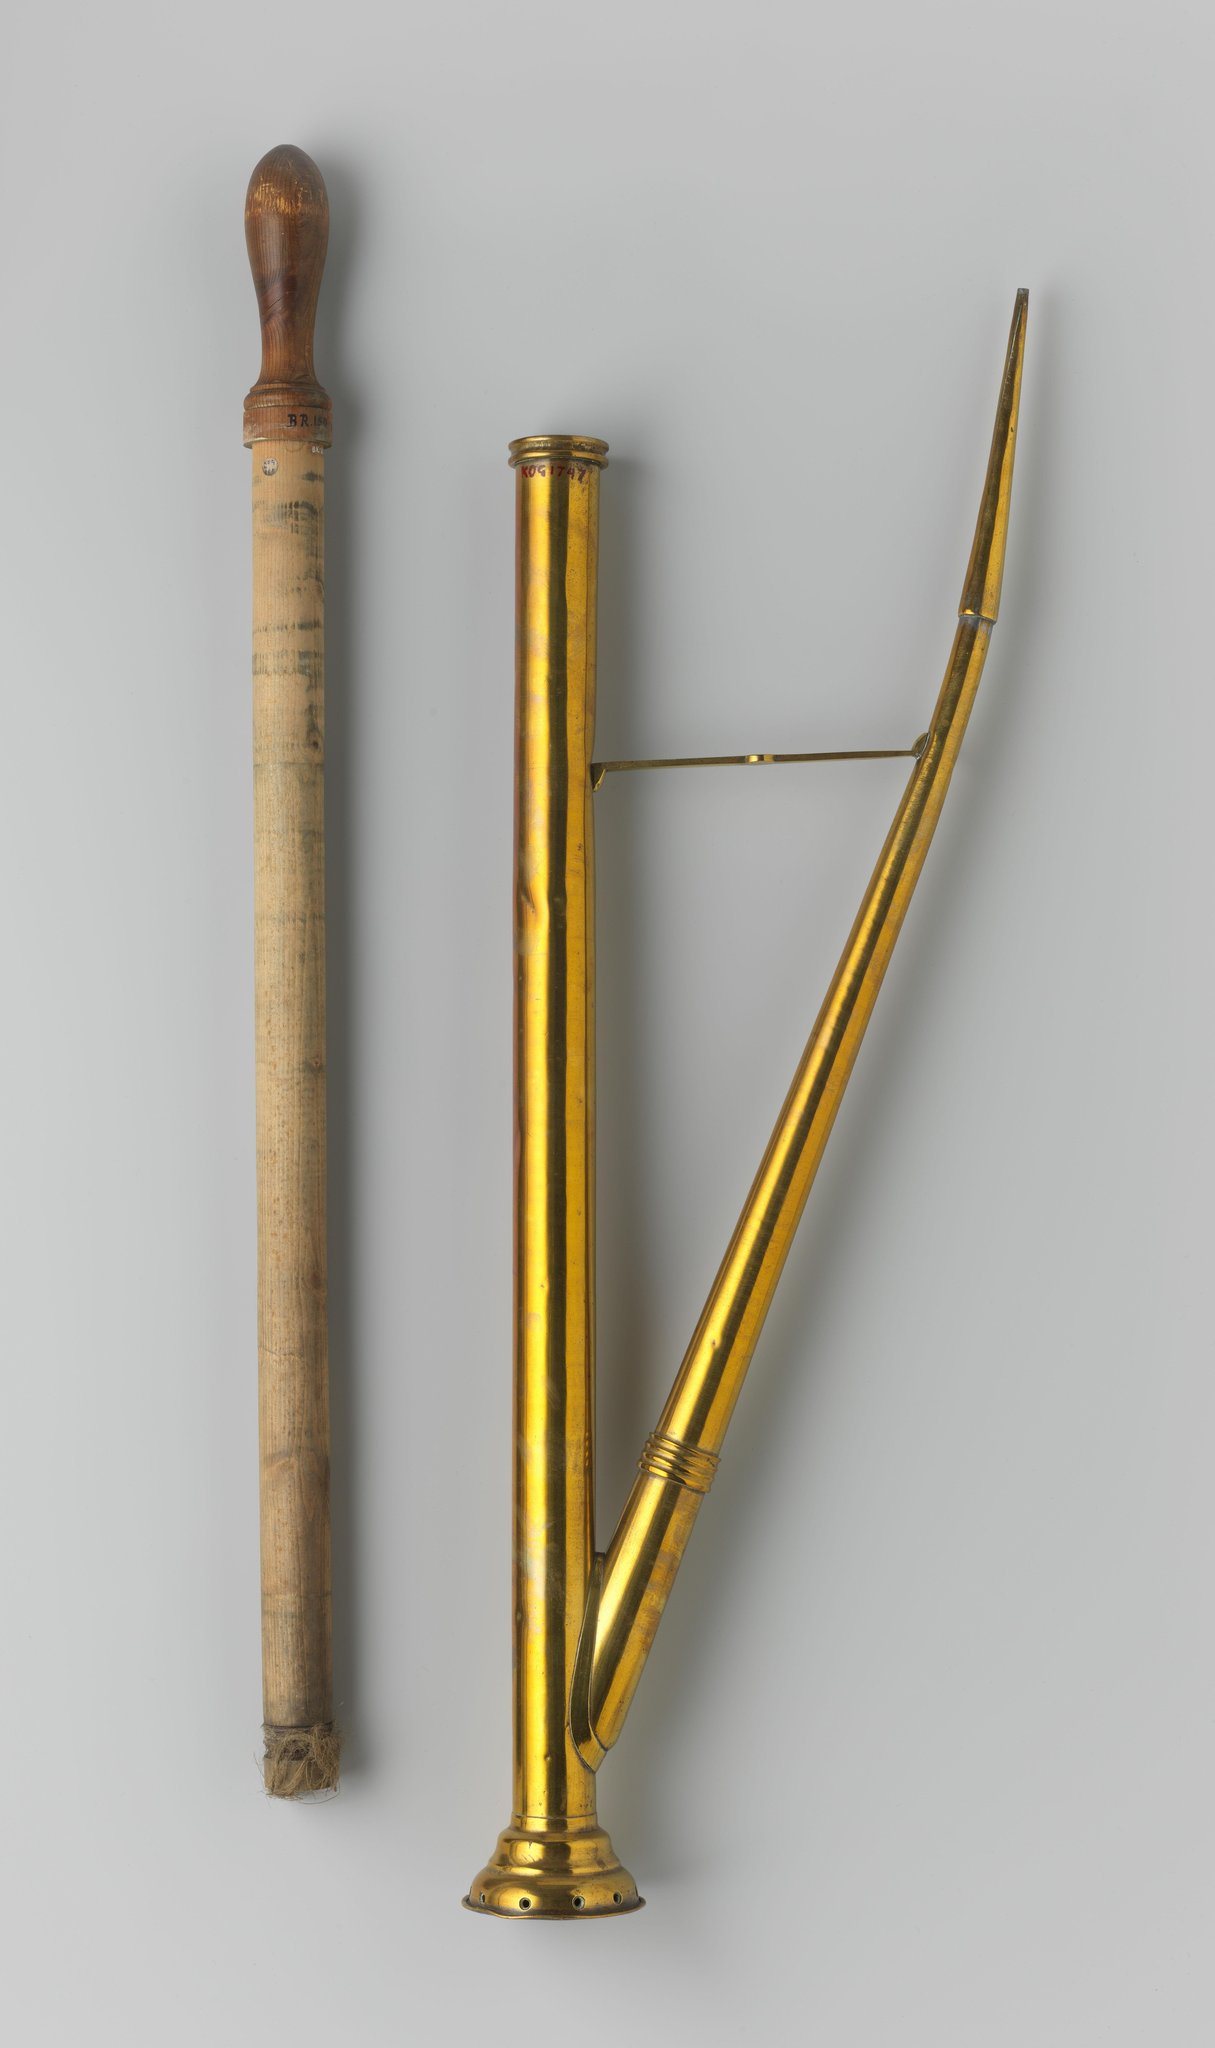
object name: glazenspuit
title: Houten onderdeel, horend bij glazenspuit op geprofileerde voet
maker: Anonymous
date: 1700-1900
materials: wood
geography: amsterdam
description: Houten onderdeel, horend bij glazenspuit op geprofileerde voet